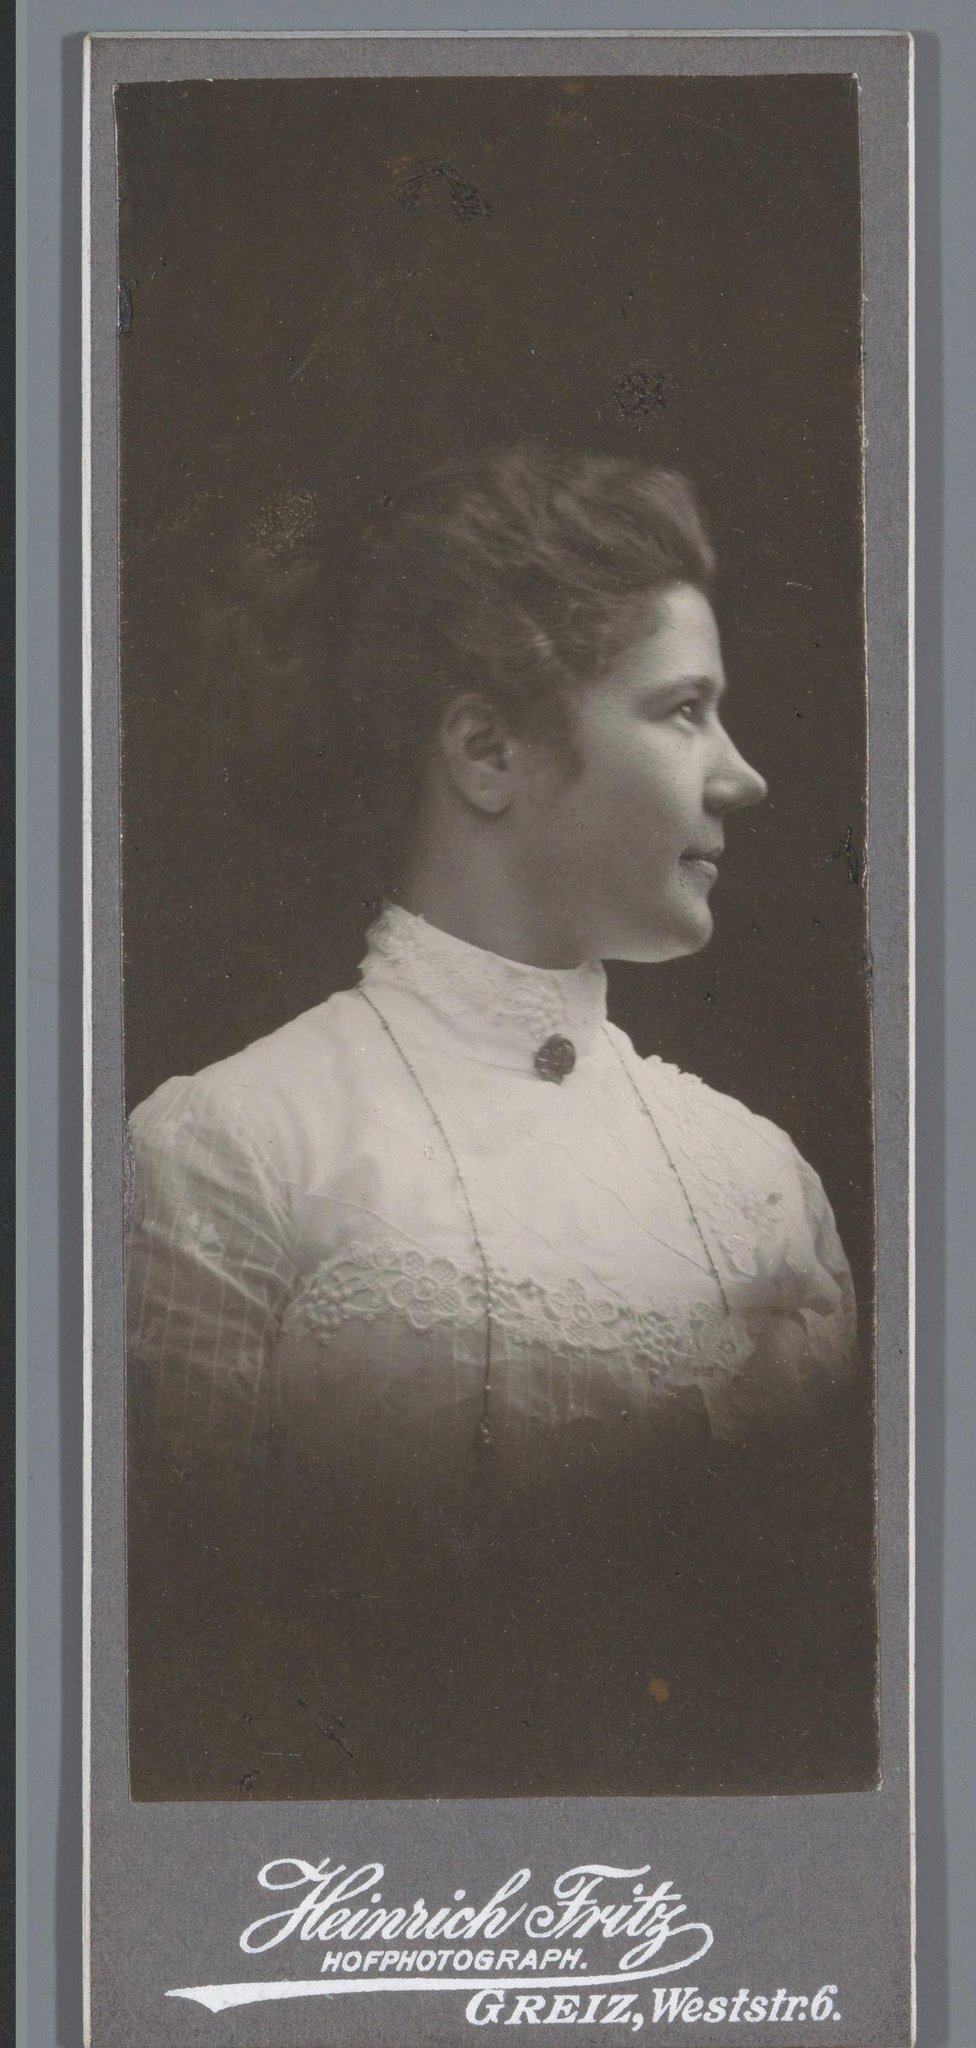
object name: carte de visite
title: Portret van een onbekende vrouw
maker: heinrich fritz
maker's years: 1831-1913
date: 1881-1914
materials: paper, cardboard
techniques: gelatin silver print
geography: greiz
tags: adult woman, anonymous historical person portrayed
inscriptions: address: ‘GREIZ, Weststr.6.’